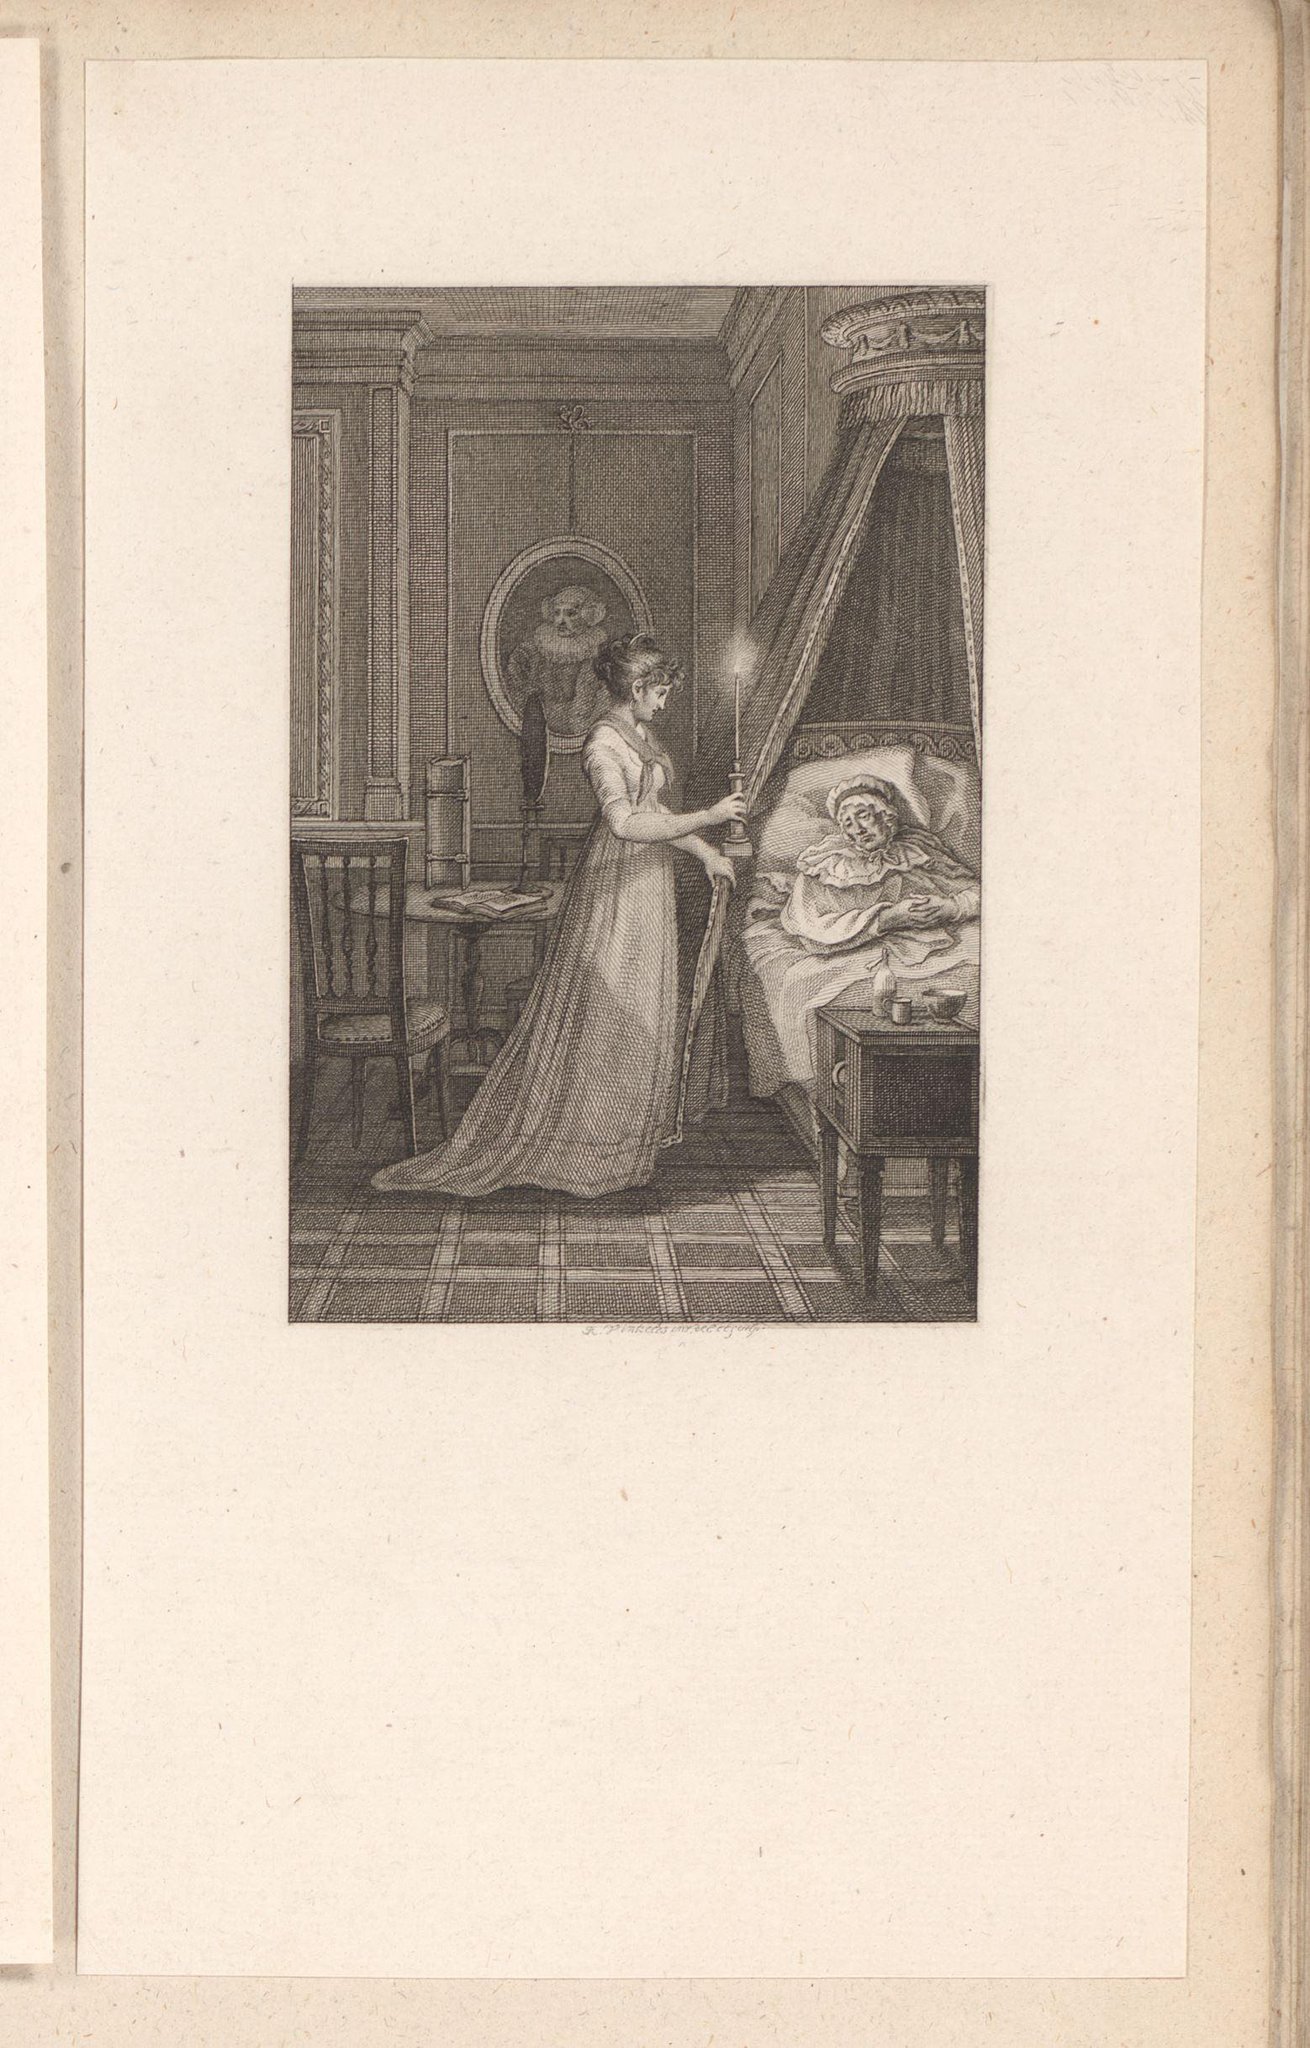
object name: print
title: Susanna Bronkhorst bij het sterfbed van mevrouw Elzevier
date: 1806-1807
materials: paper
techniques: engraving, etching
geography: haarlem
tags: death of human being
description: In een donkere kamer staat een meisje met een kaars bij een oude vrouw, liggend in bed. Zij heeft haar ogen gesloten en haar handen gevouwen. De prent maakt deel uit van een album.